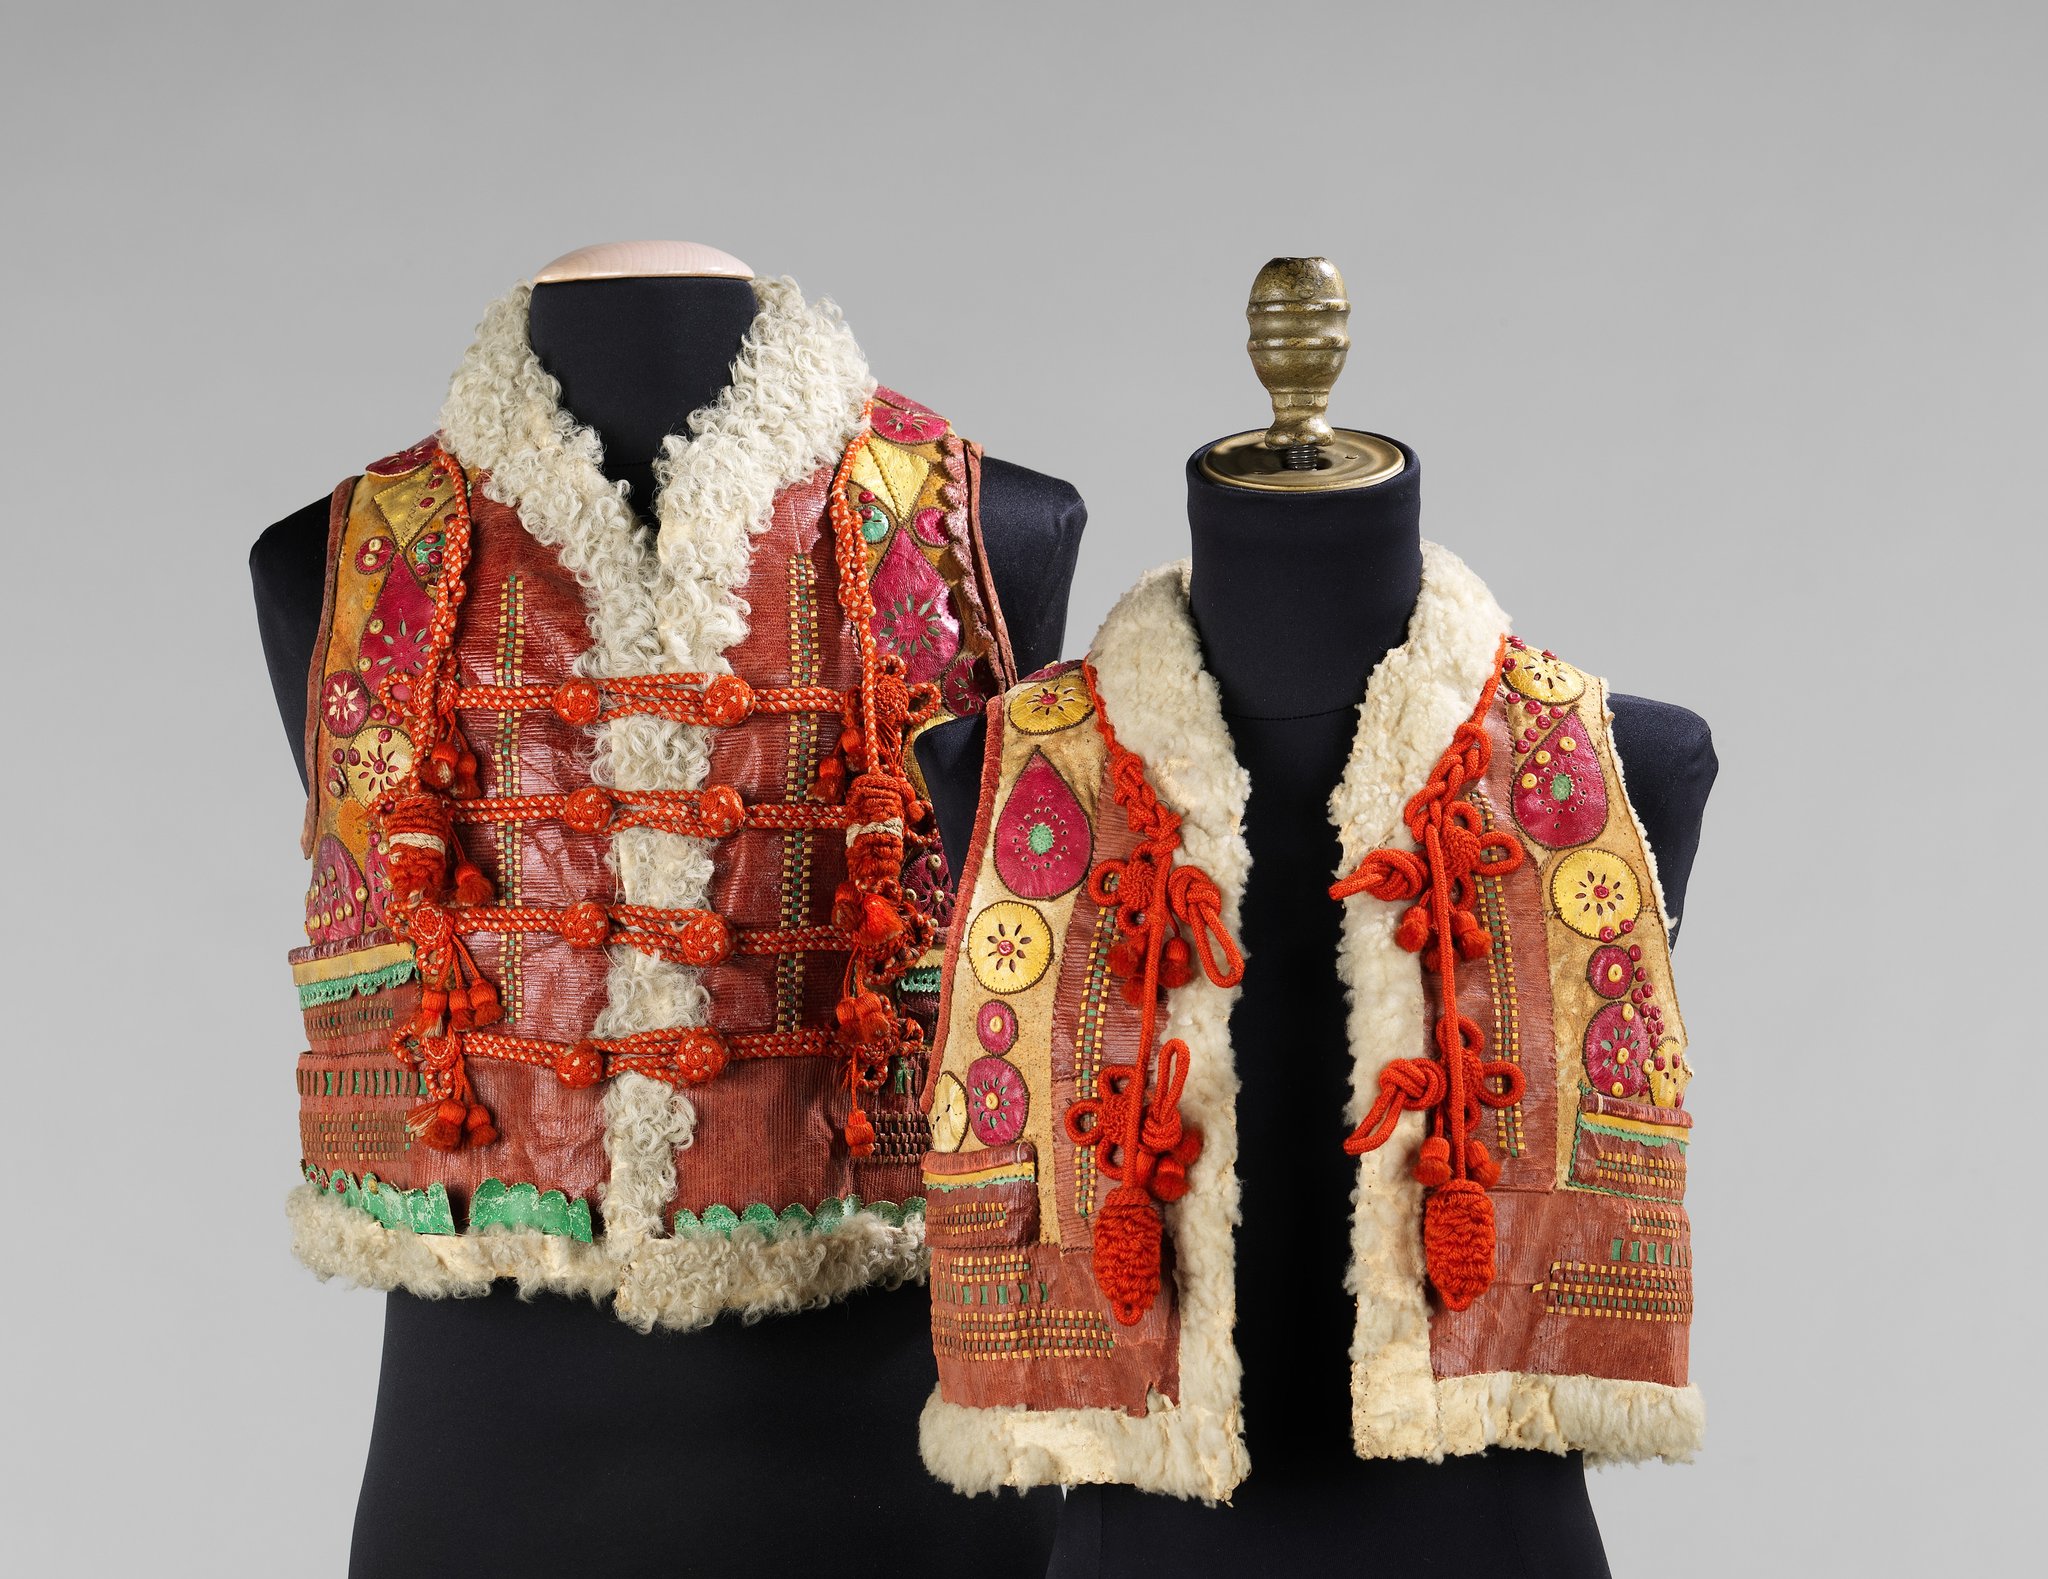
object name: vest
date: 1867-1900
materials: leather, wool